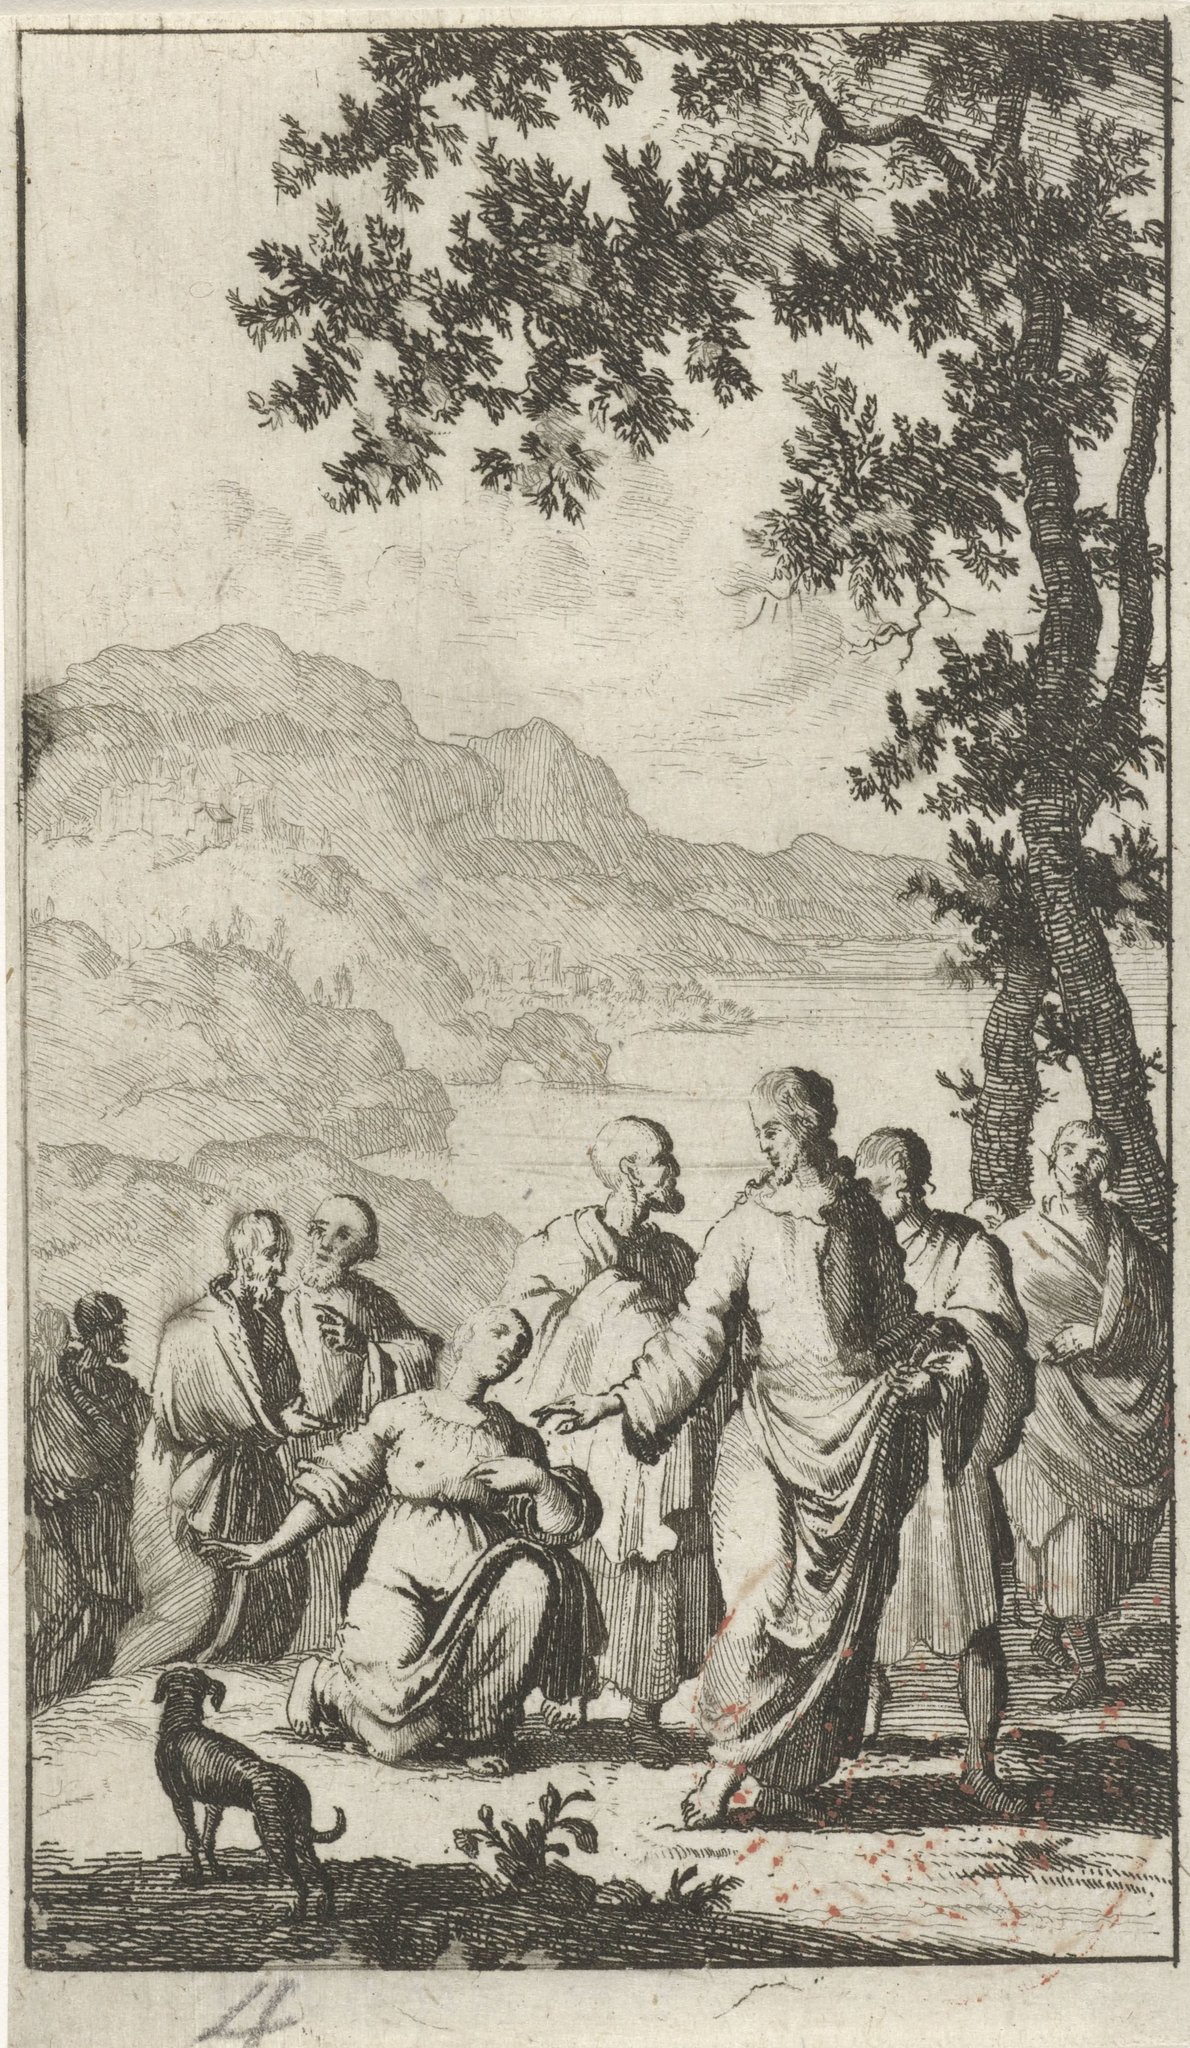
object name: print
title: Vierentwintig scènes uit het Nieuwe Testament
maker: Anonymous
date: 1681-1762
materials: paper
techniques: etching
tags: a canaanite woman kneels before christ, asking him to heal her daughter; the metaphor of the dogs and bread (matthew 15:21-28; mark 7:24-30)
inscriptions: collector's mark: Lugt 240, number: ‘4’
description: Kopie naar prent van J. Luyken, mogelijk voor het eerst verschenen in: Het Nieuwe Testament ofte alle Boecken des Nieuwen Verbondts onses Heeren Iesu Christi. Amsterdam: Hieronymus Sweerts, Jan ten Hoorn, Jan Bouman en Daniel van den Dalen, 1681.